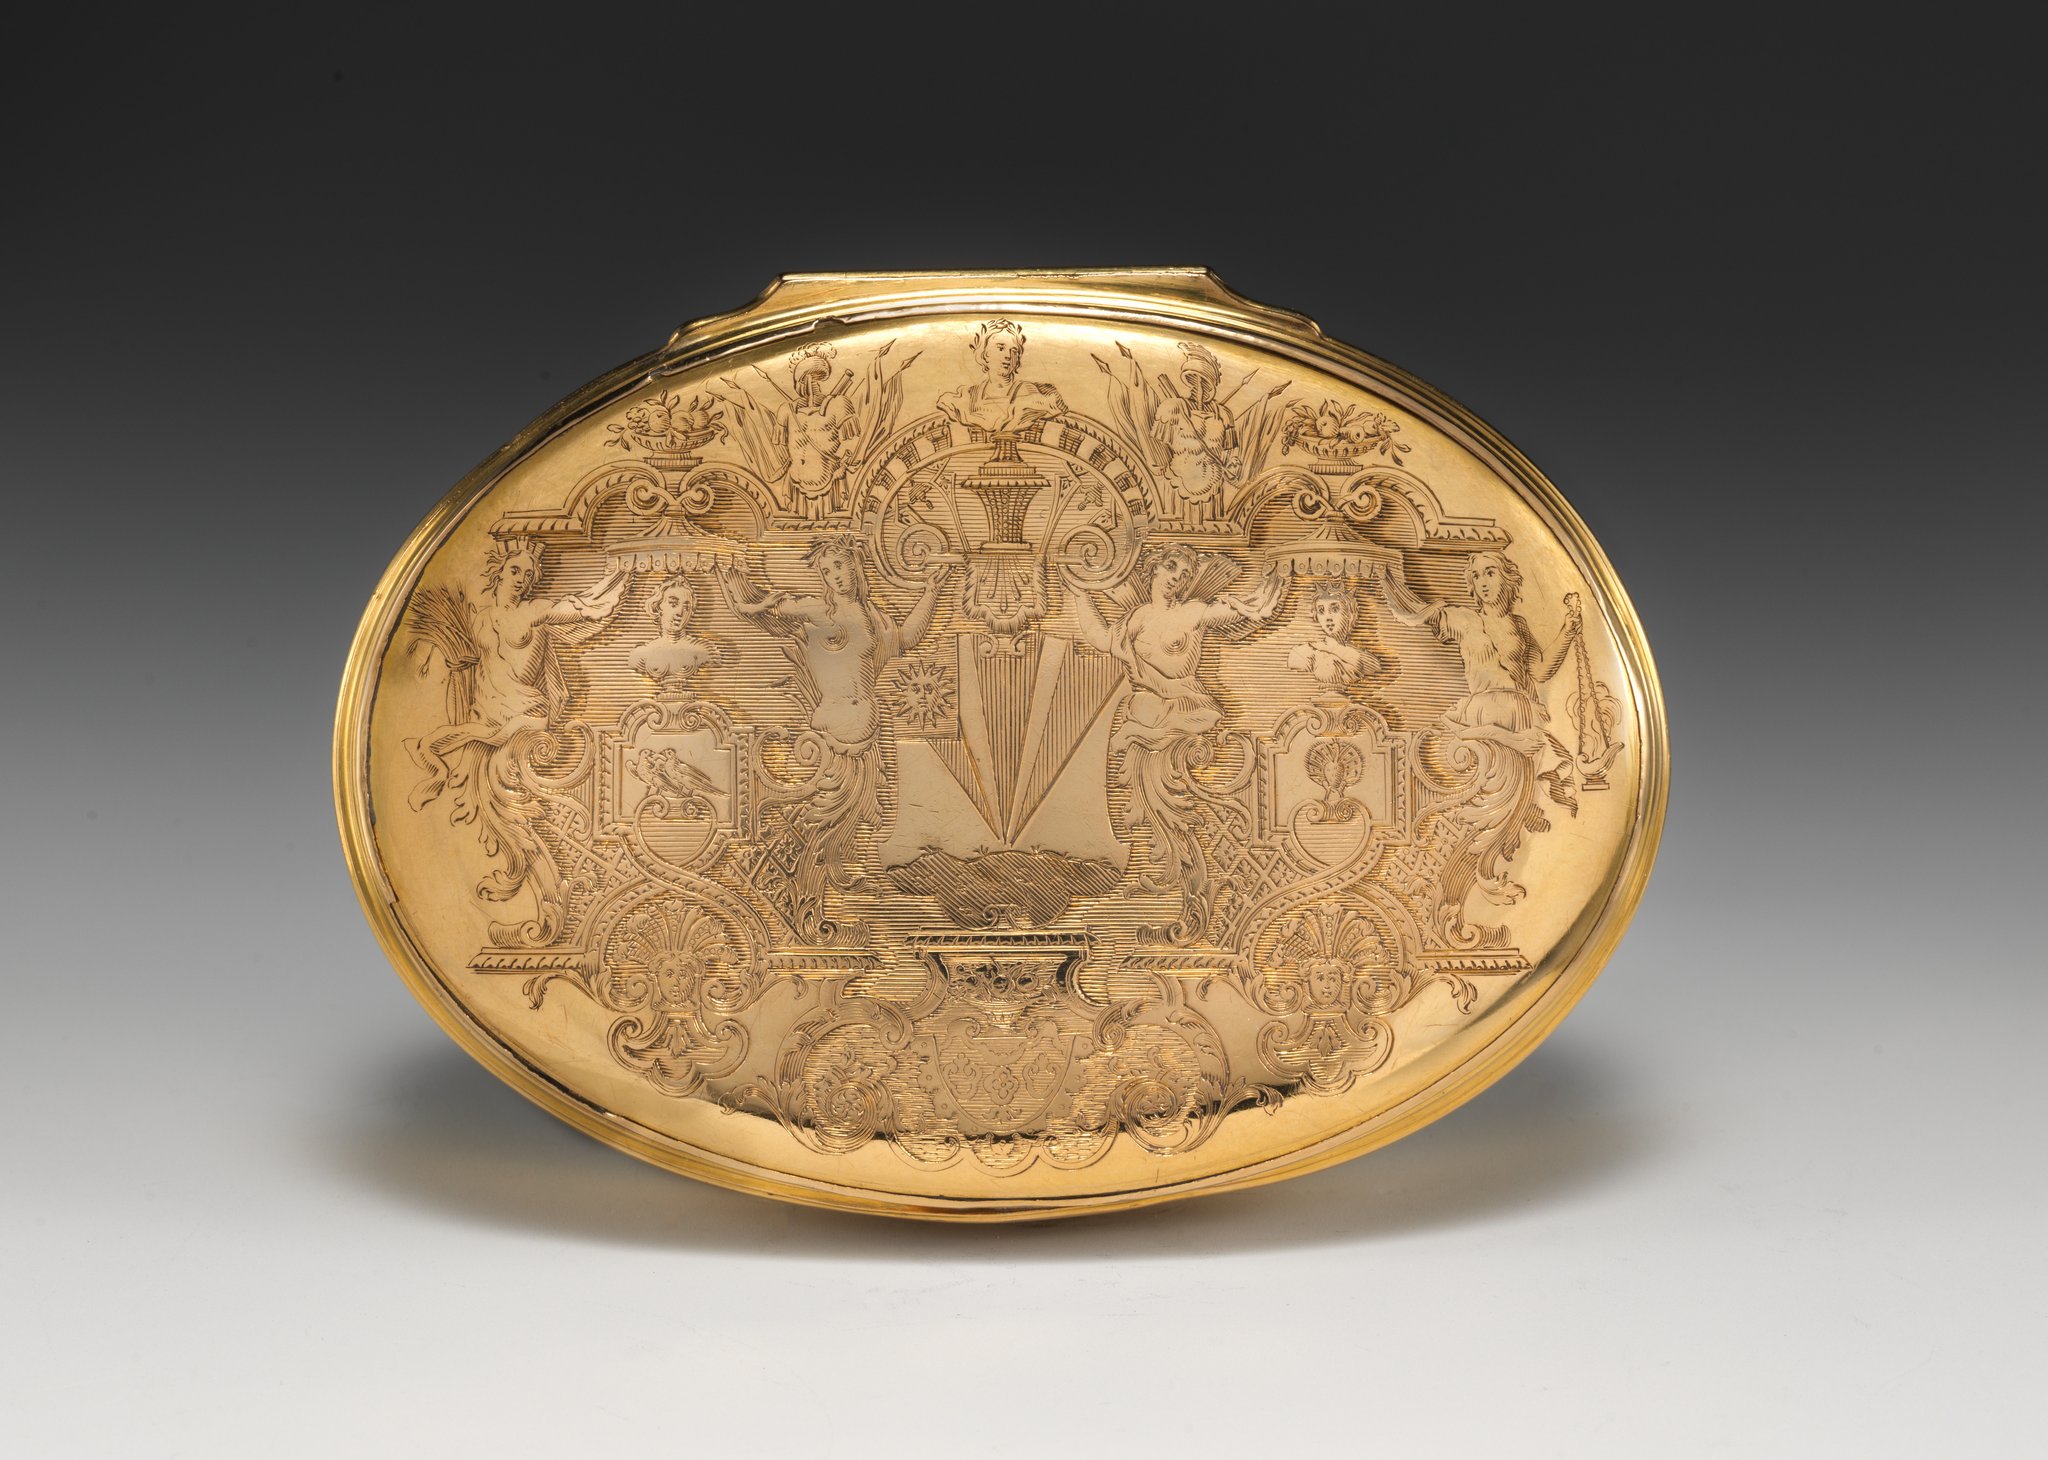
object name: snuffbox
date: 1710-1720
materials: gold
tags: birds,women,trophies